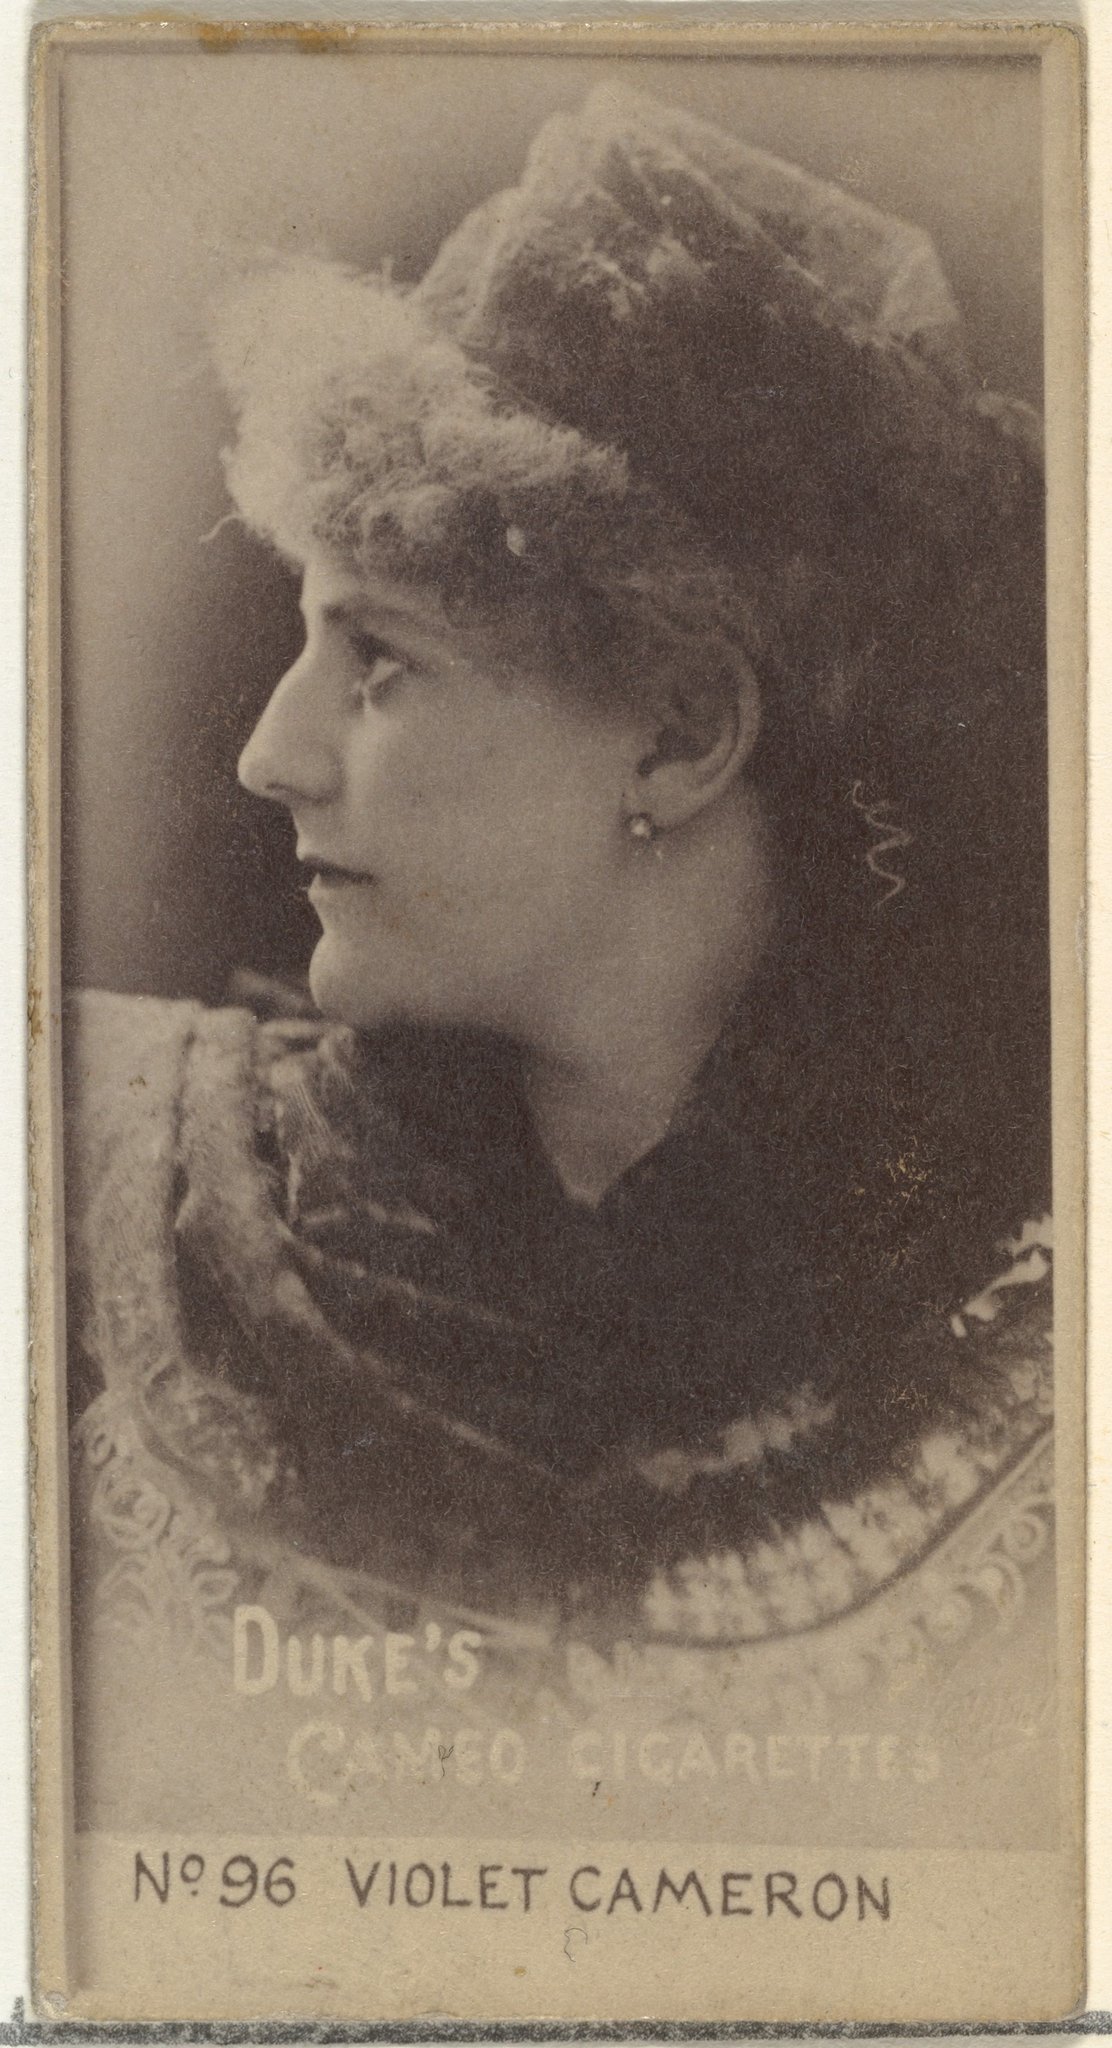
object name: photograph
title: Card Number 96, Violet Cameron, from the Actors and Actresses series (N145-4) issued by Duke Sons & Co. to promote Cameo Cigarettes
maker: w. duke, sons & co.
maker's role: publisher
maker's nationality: american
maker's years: 1870-1920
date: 1880-1889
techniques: albumen silver print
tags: women,actresses